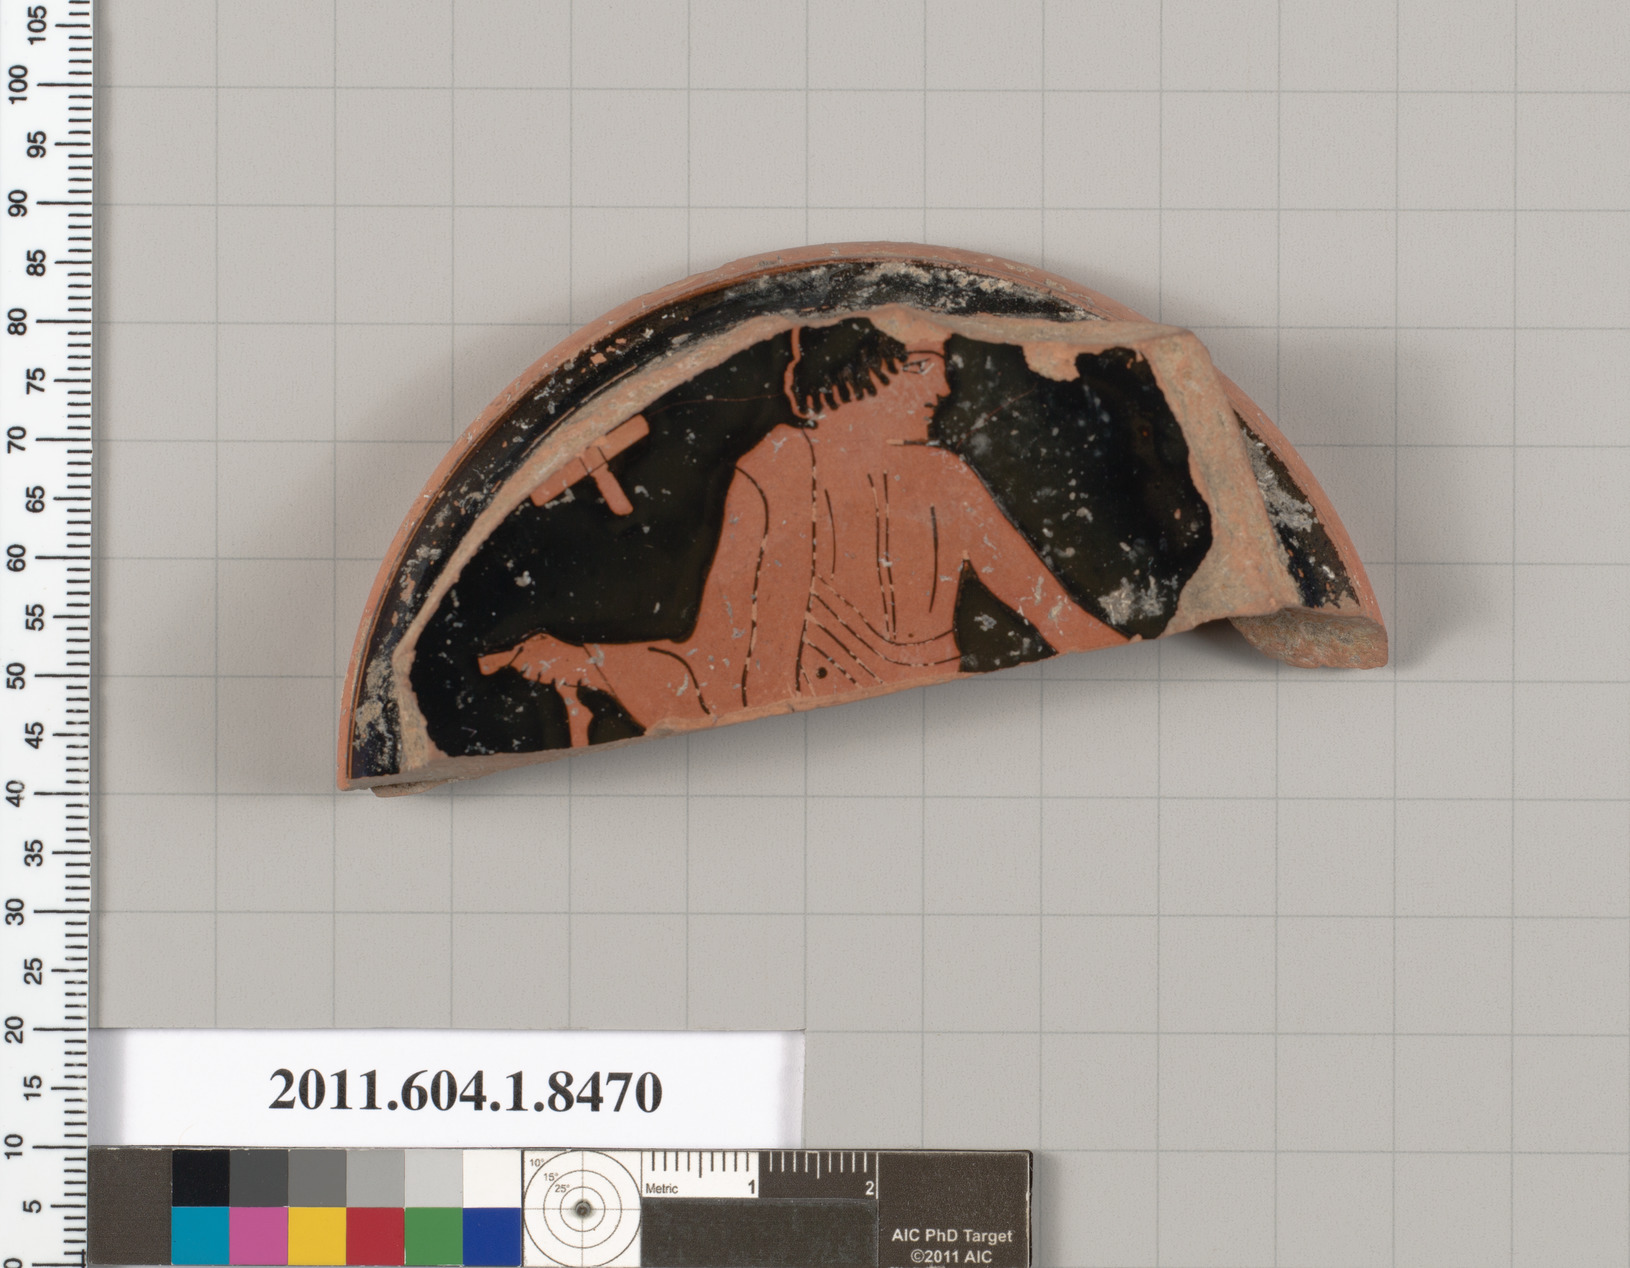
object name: kylix fragment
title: Terracotta fragment of a stemless kylix (drinking cup)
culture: greek, attic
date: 470-450 BCE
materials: terracotta